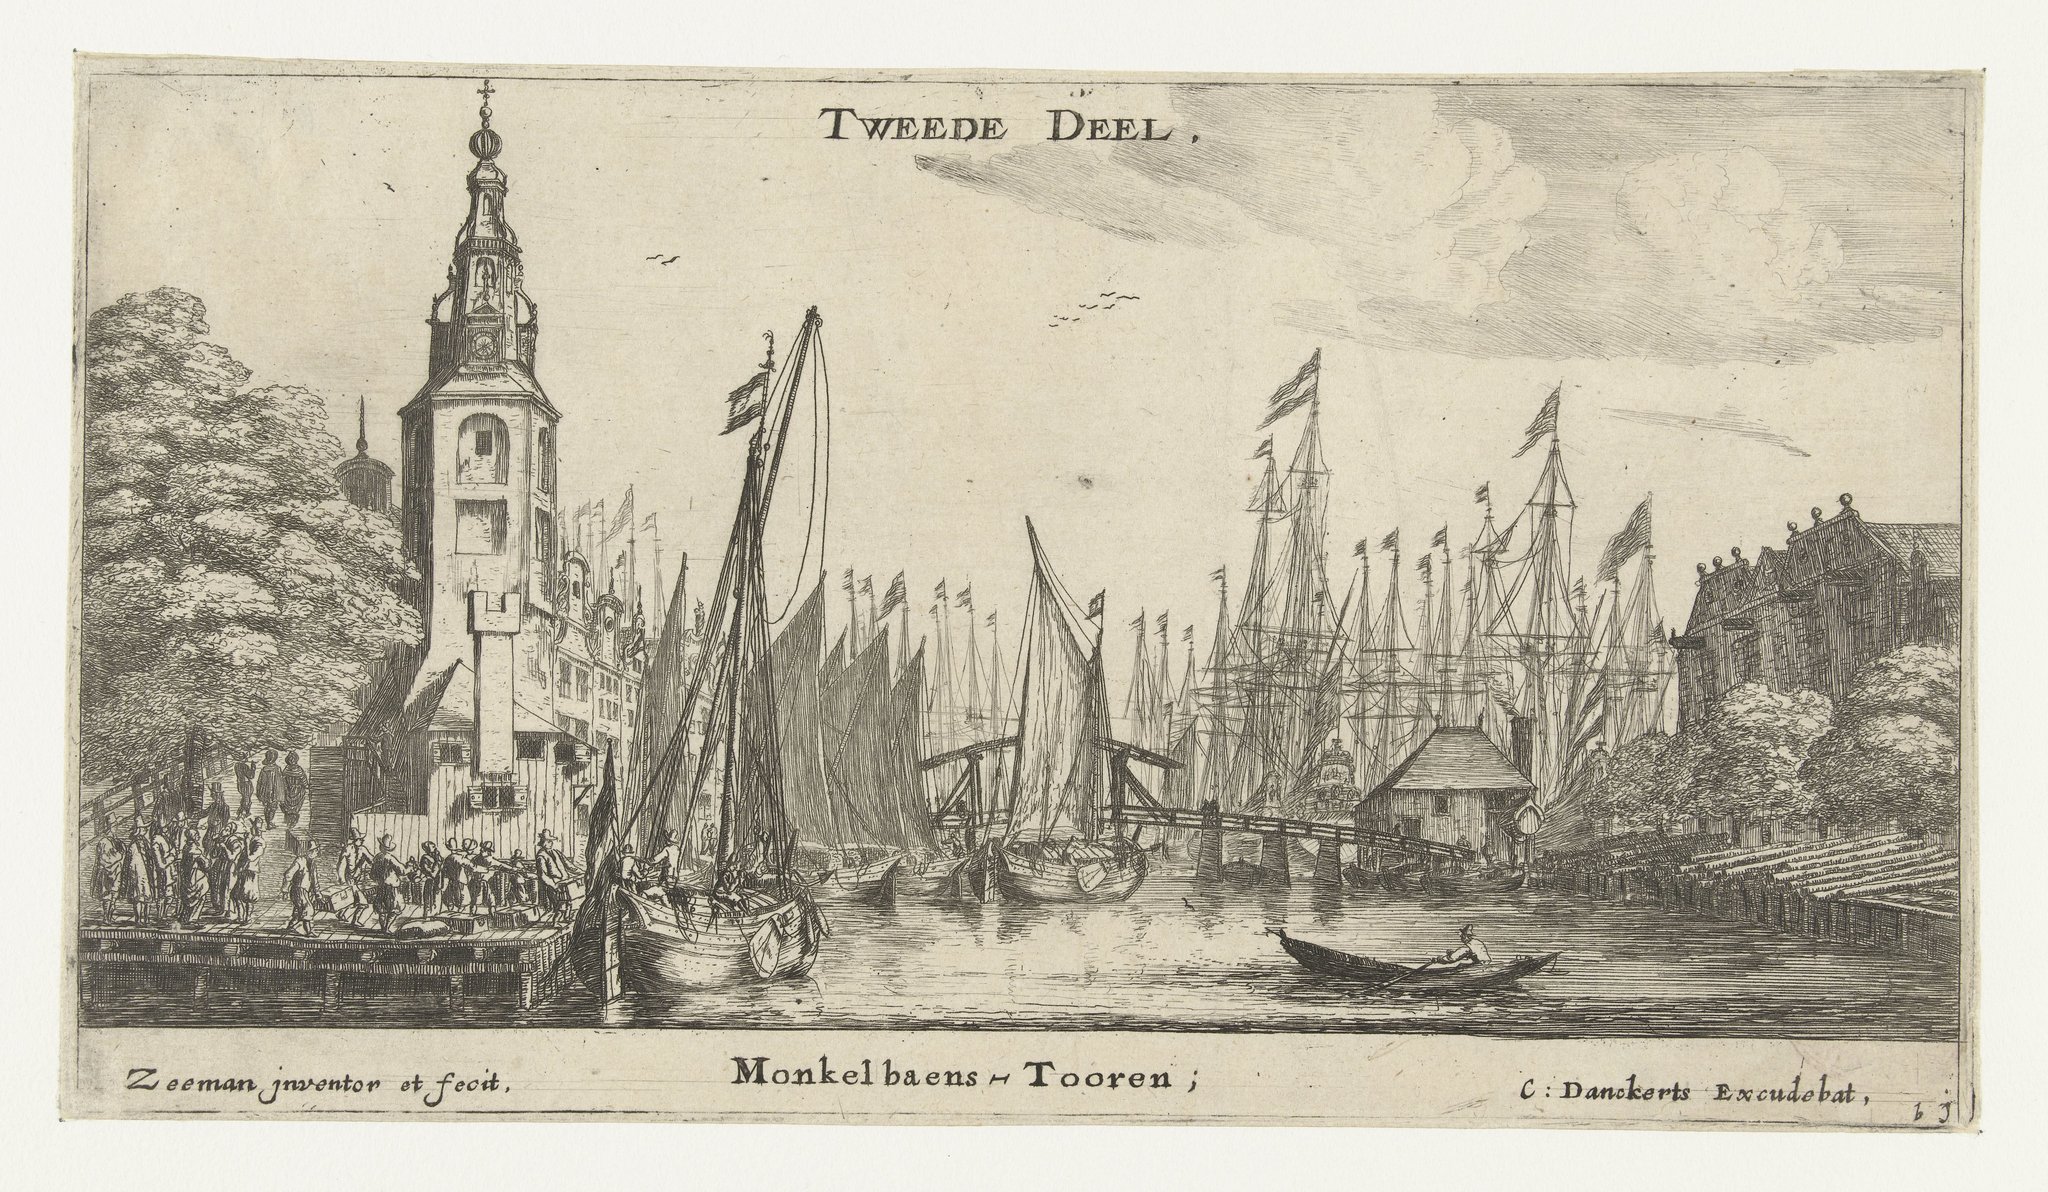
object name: print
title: Verschillende schepen en stadsgezichten van Amsterdam, tweede deel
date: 1652-1654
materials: paper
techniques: drypoint, etching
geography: netherlands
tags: city-view in general; 'veduta', towers ~ fortified city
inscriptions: collector's mark: Lugt 12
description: Links de Montelbaanstoren en het inladen van een schip. Een brug over het water met daarachter masten van vele zeilschepen.